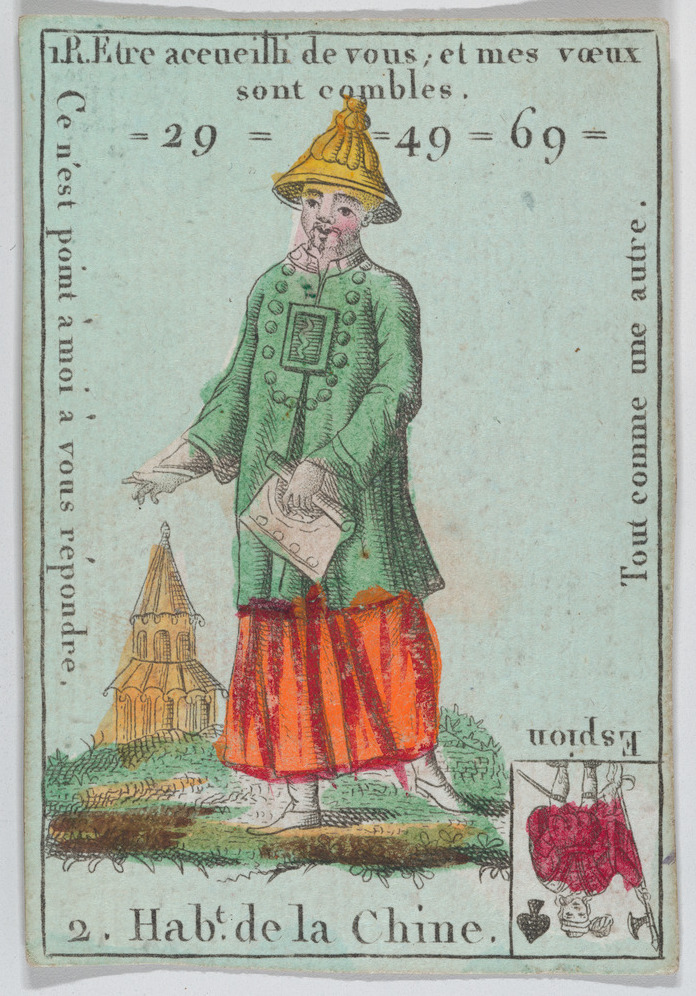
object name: print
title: Hab.t de la Chine from playing cards "Jeu d'Or"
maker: anonymous, french, 18th century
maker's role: artist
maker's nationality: french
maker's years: 1700-1800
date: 1700-1799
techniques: etching, hand coloring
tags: men,playing cards